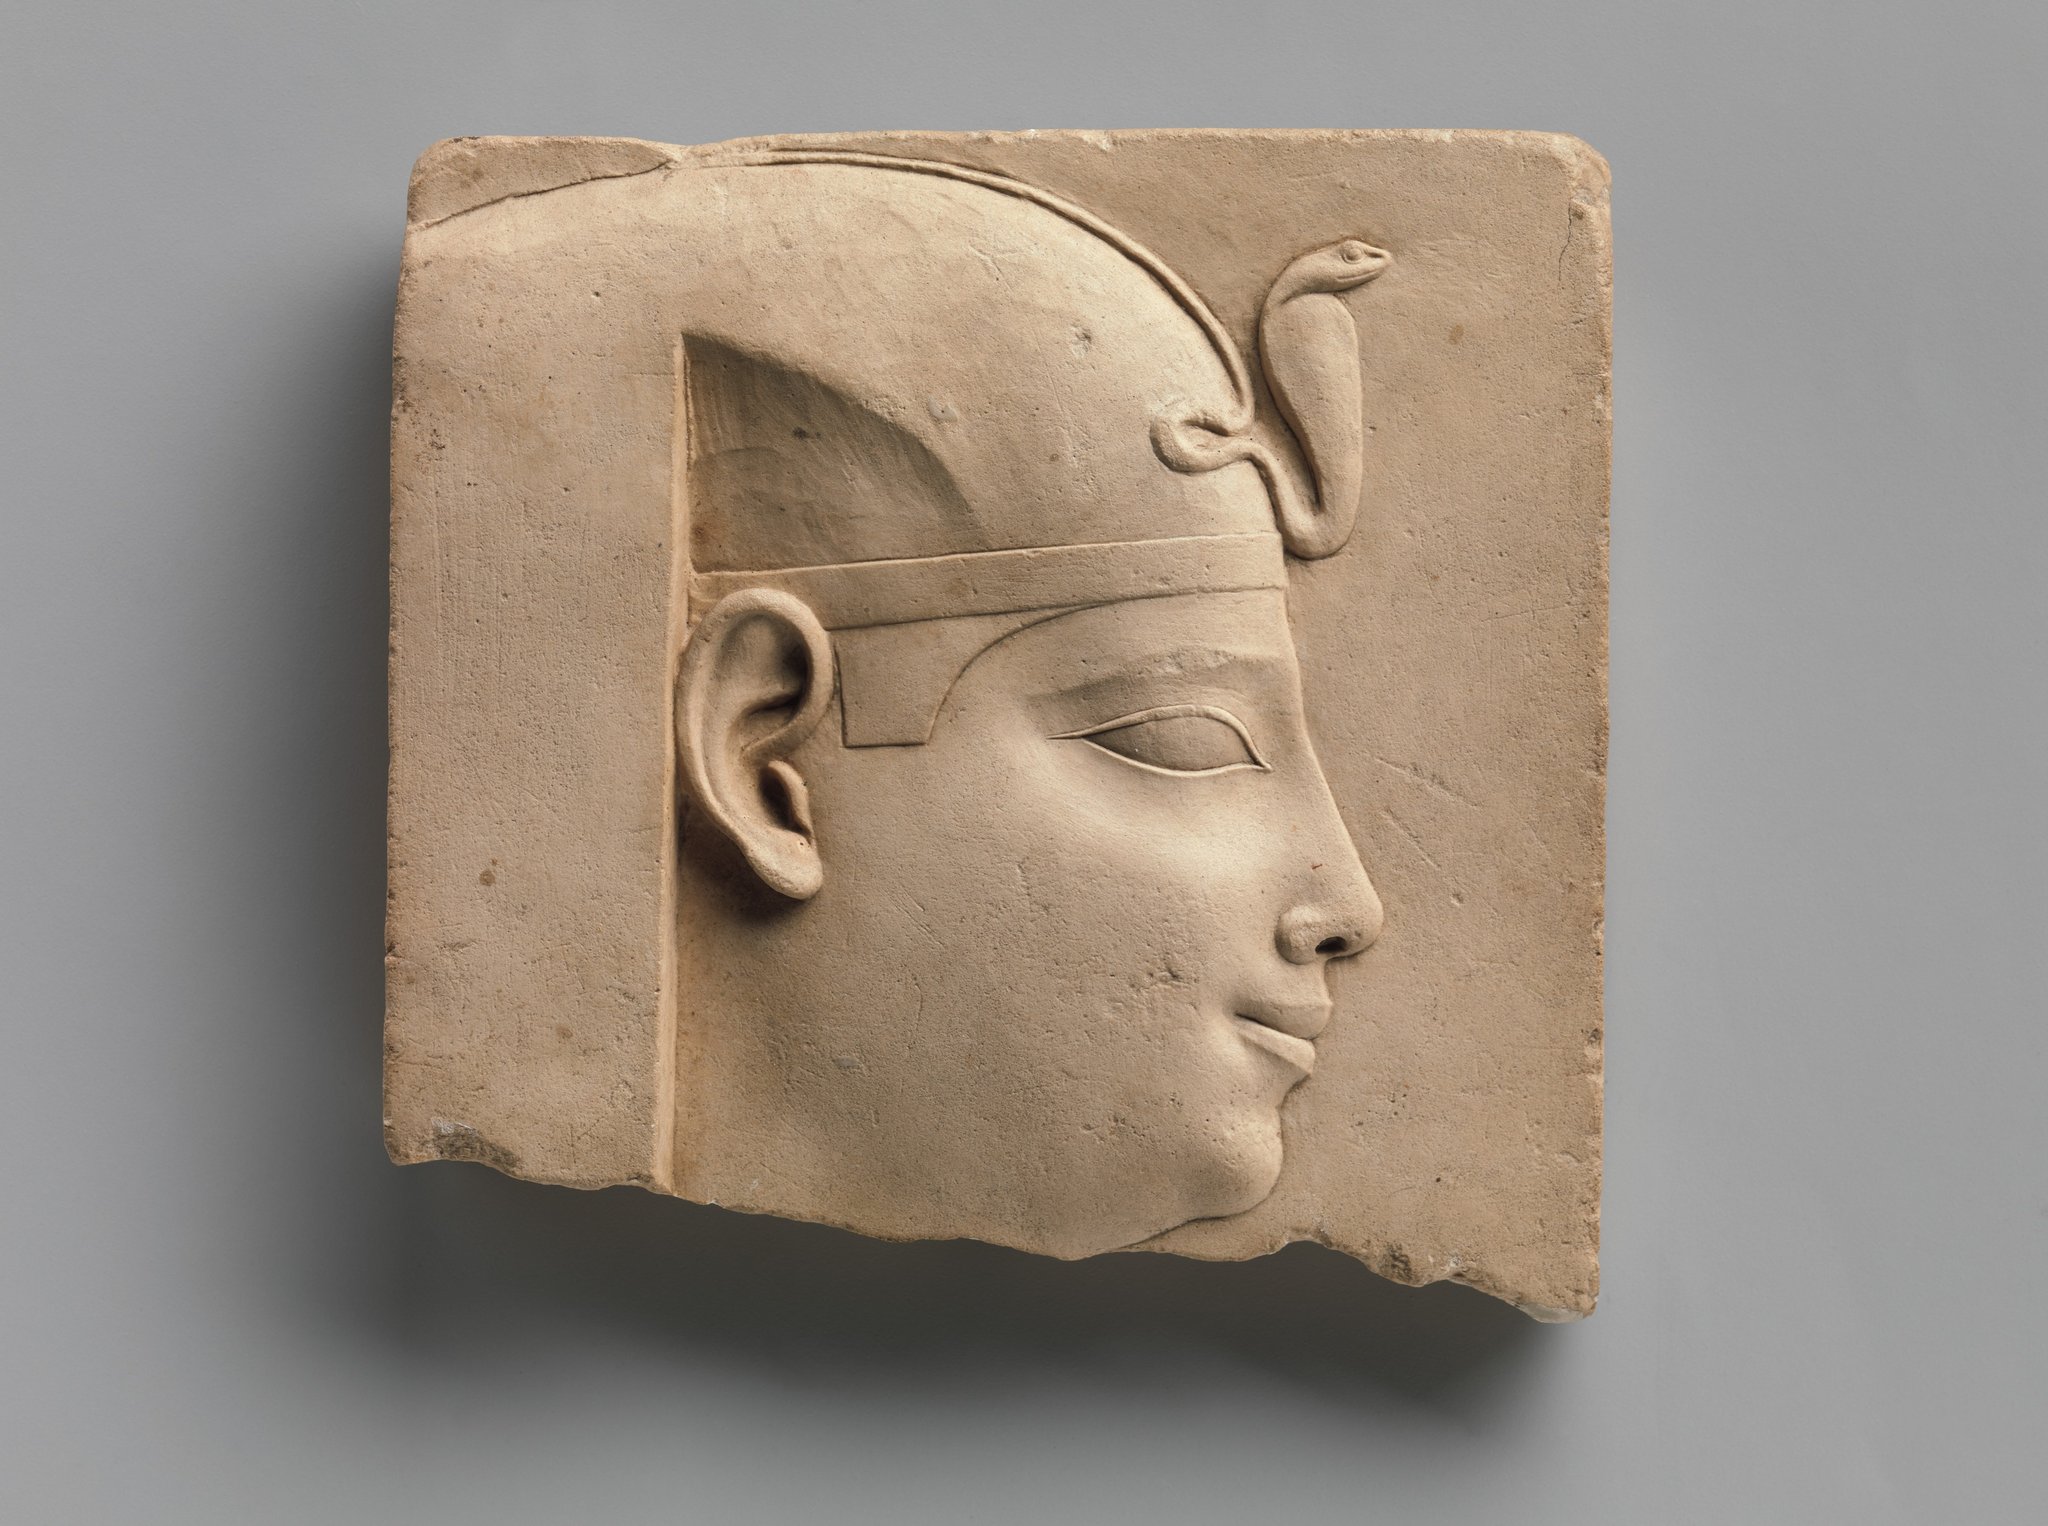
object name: sculptor's model votive, plaque with head of a king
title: Plaque with head of a king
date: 400-200 BCE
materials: limestone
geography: egypt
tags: kings,heads,snakes